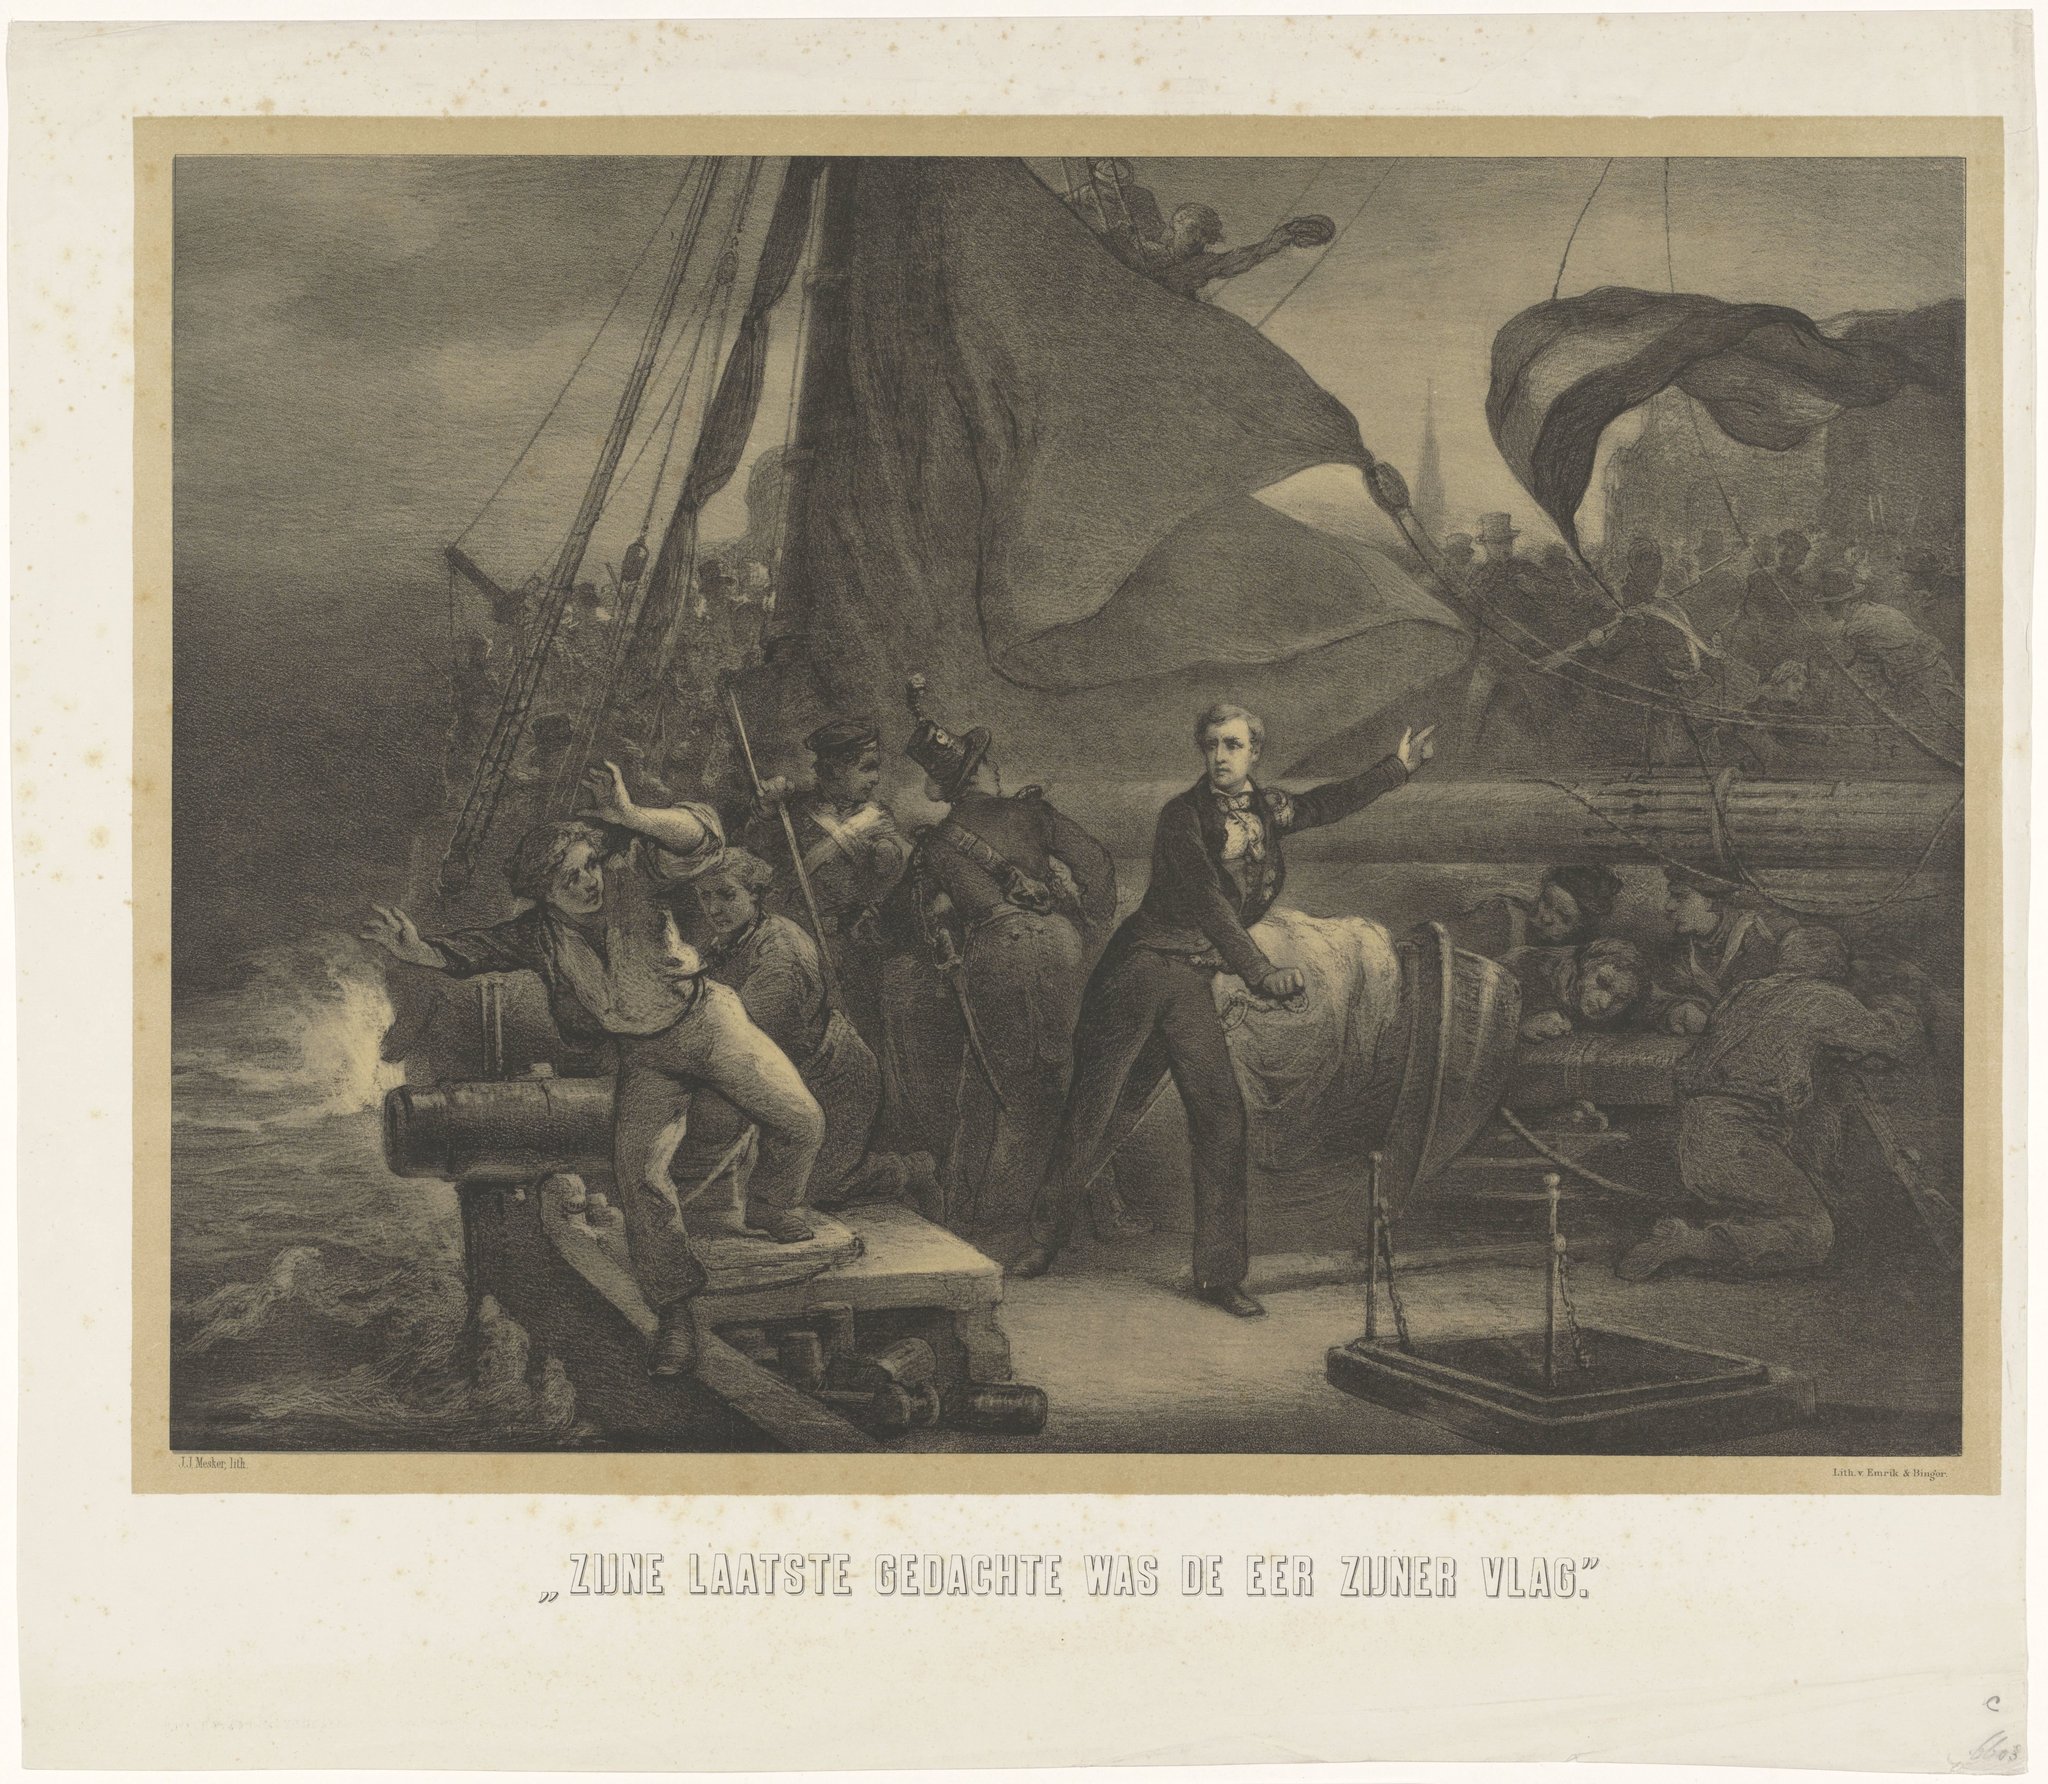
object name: print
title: Jan van Speyk op het punt de lont in het ruim te gooien, 1831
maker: jan mesker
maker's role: print maker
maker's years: 1843-1890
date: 1853-1890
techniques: printmaking, lithograph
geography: haarlem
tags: amsterdam, antwerp, jan van speyk, seeking death, suicide, gunpowder disaster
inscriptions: collector's mark: Lugt 2228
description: De overrompeling van de kanonneerboot van Jan van Speyk door Belgische opstandelingen, 5 februari 1831. Jan van Speyk staat op het punt de brandende lont in het ruim te gooien, met zijn linkerhand wijst hij naar de wapperende Nederlandse vlag. Links springt een jongen nog overboord.